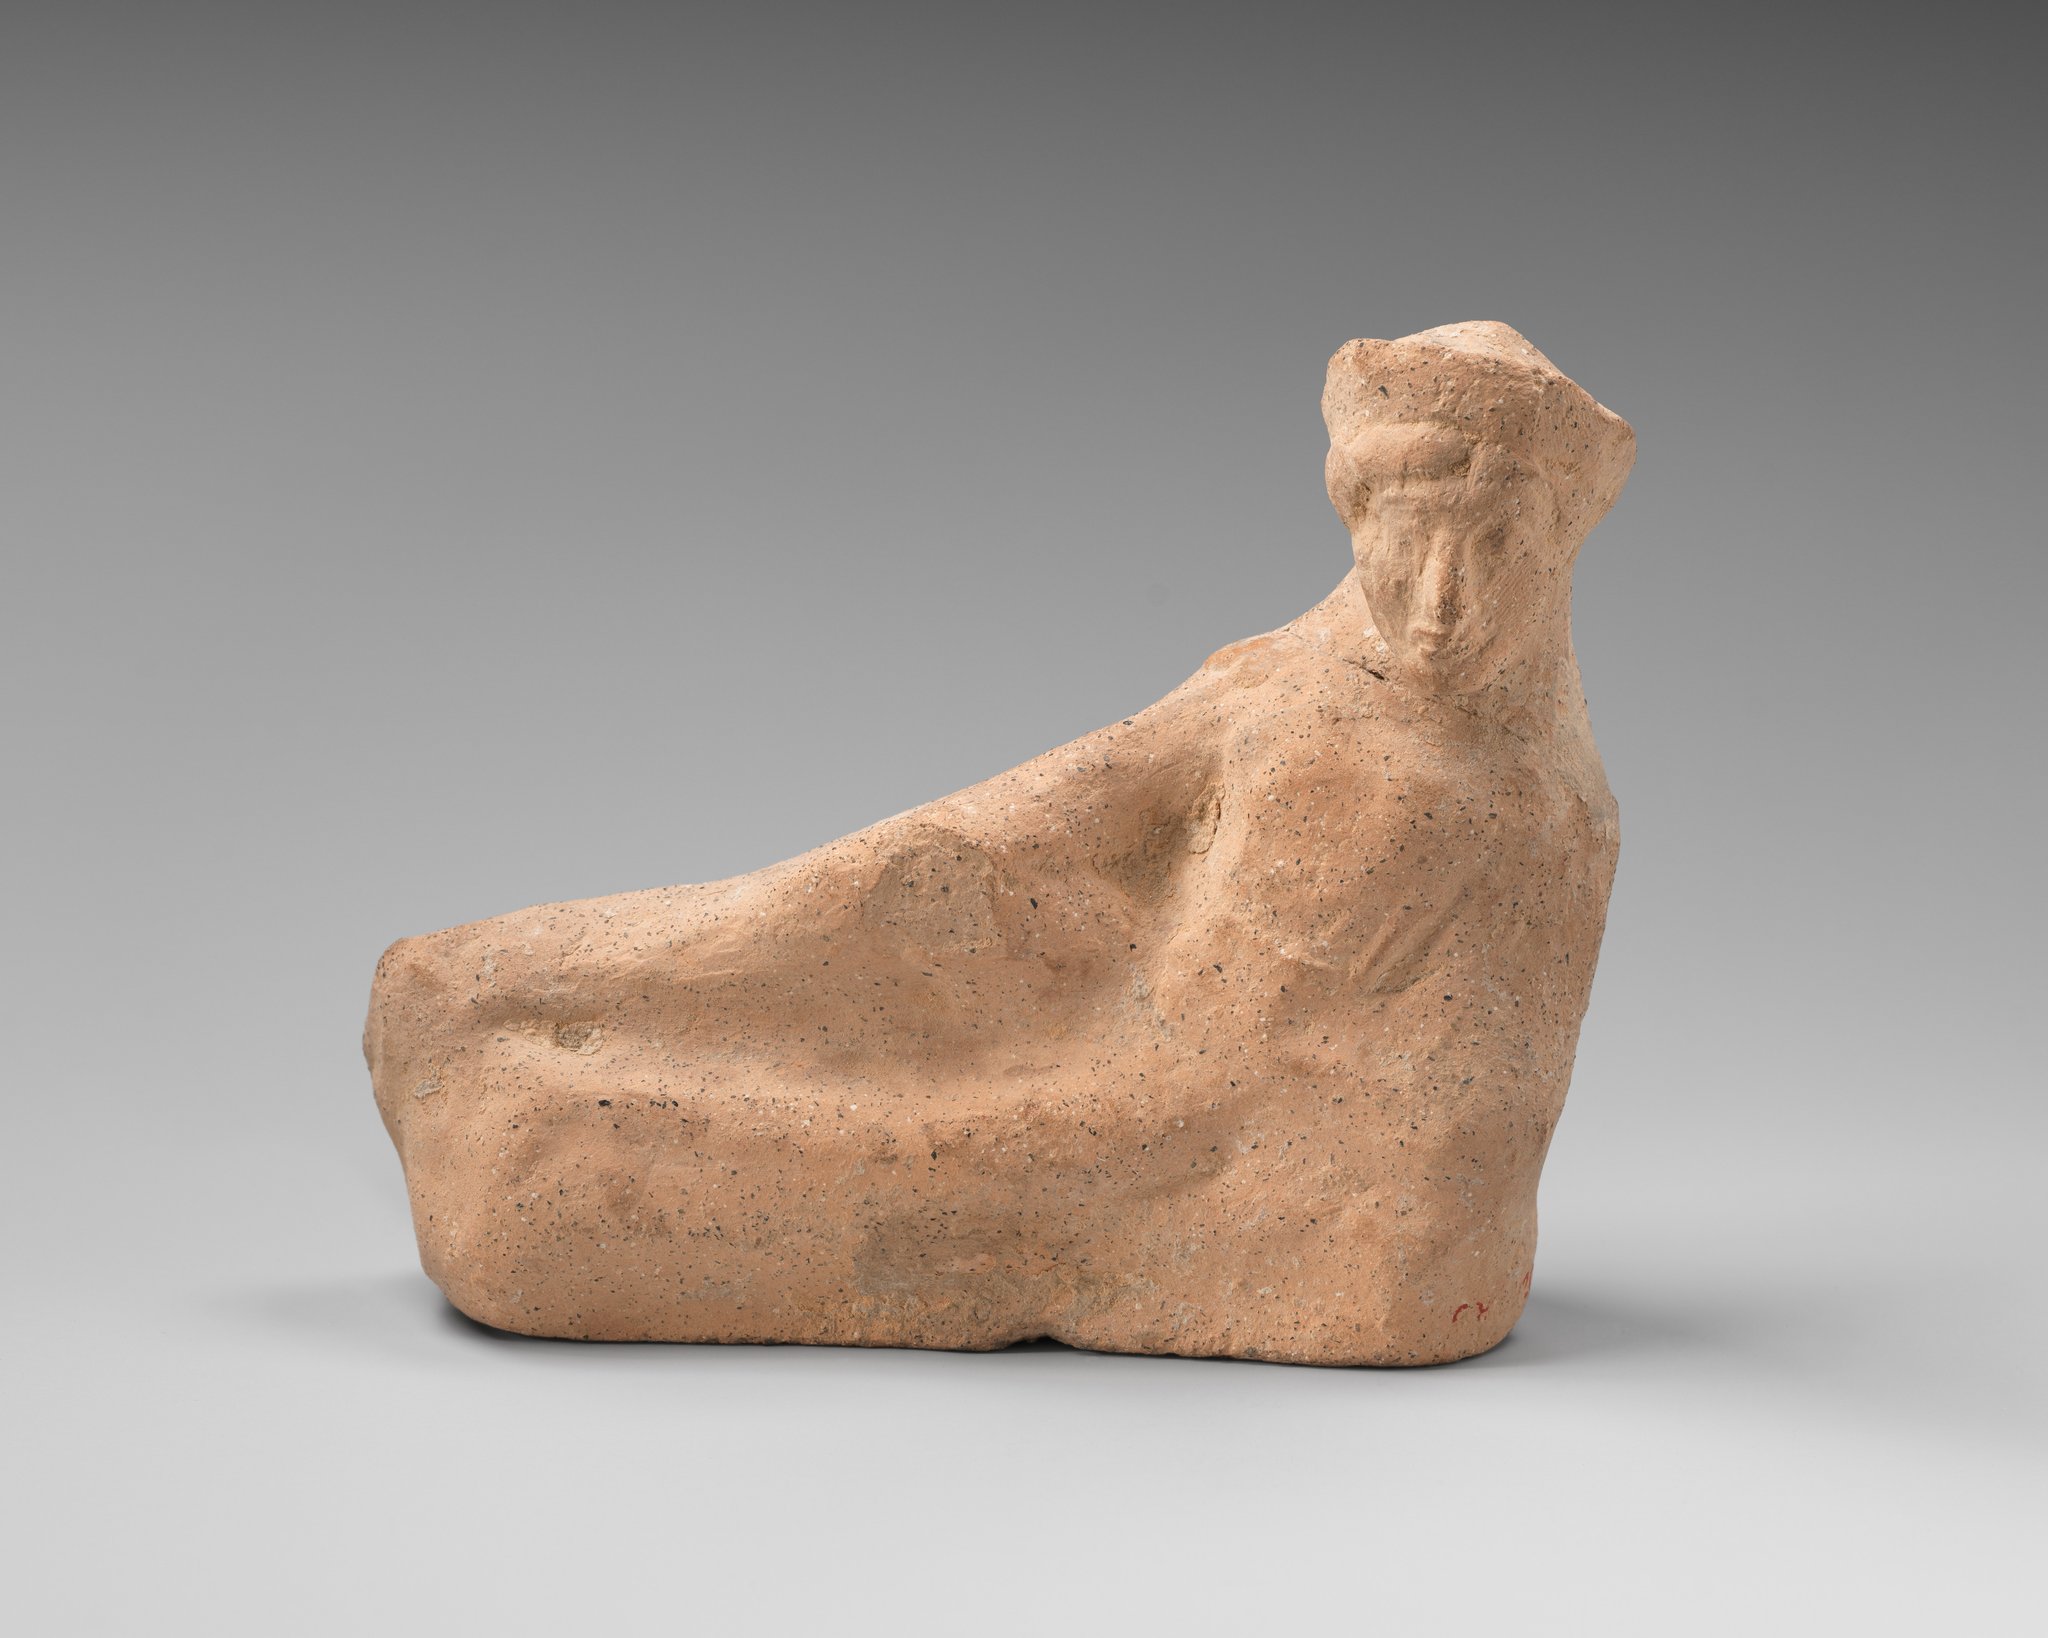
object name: statuette of a woman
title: Terracotta statuette of a reclining youth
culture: cypriot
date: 400-301 BCE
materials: terracotta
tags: men